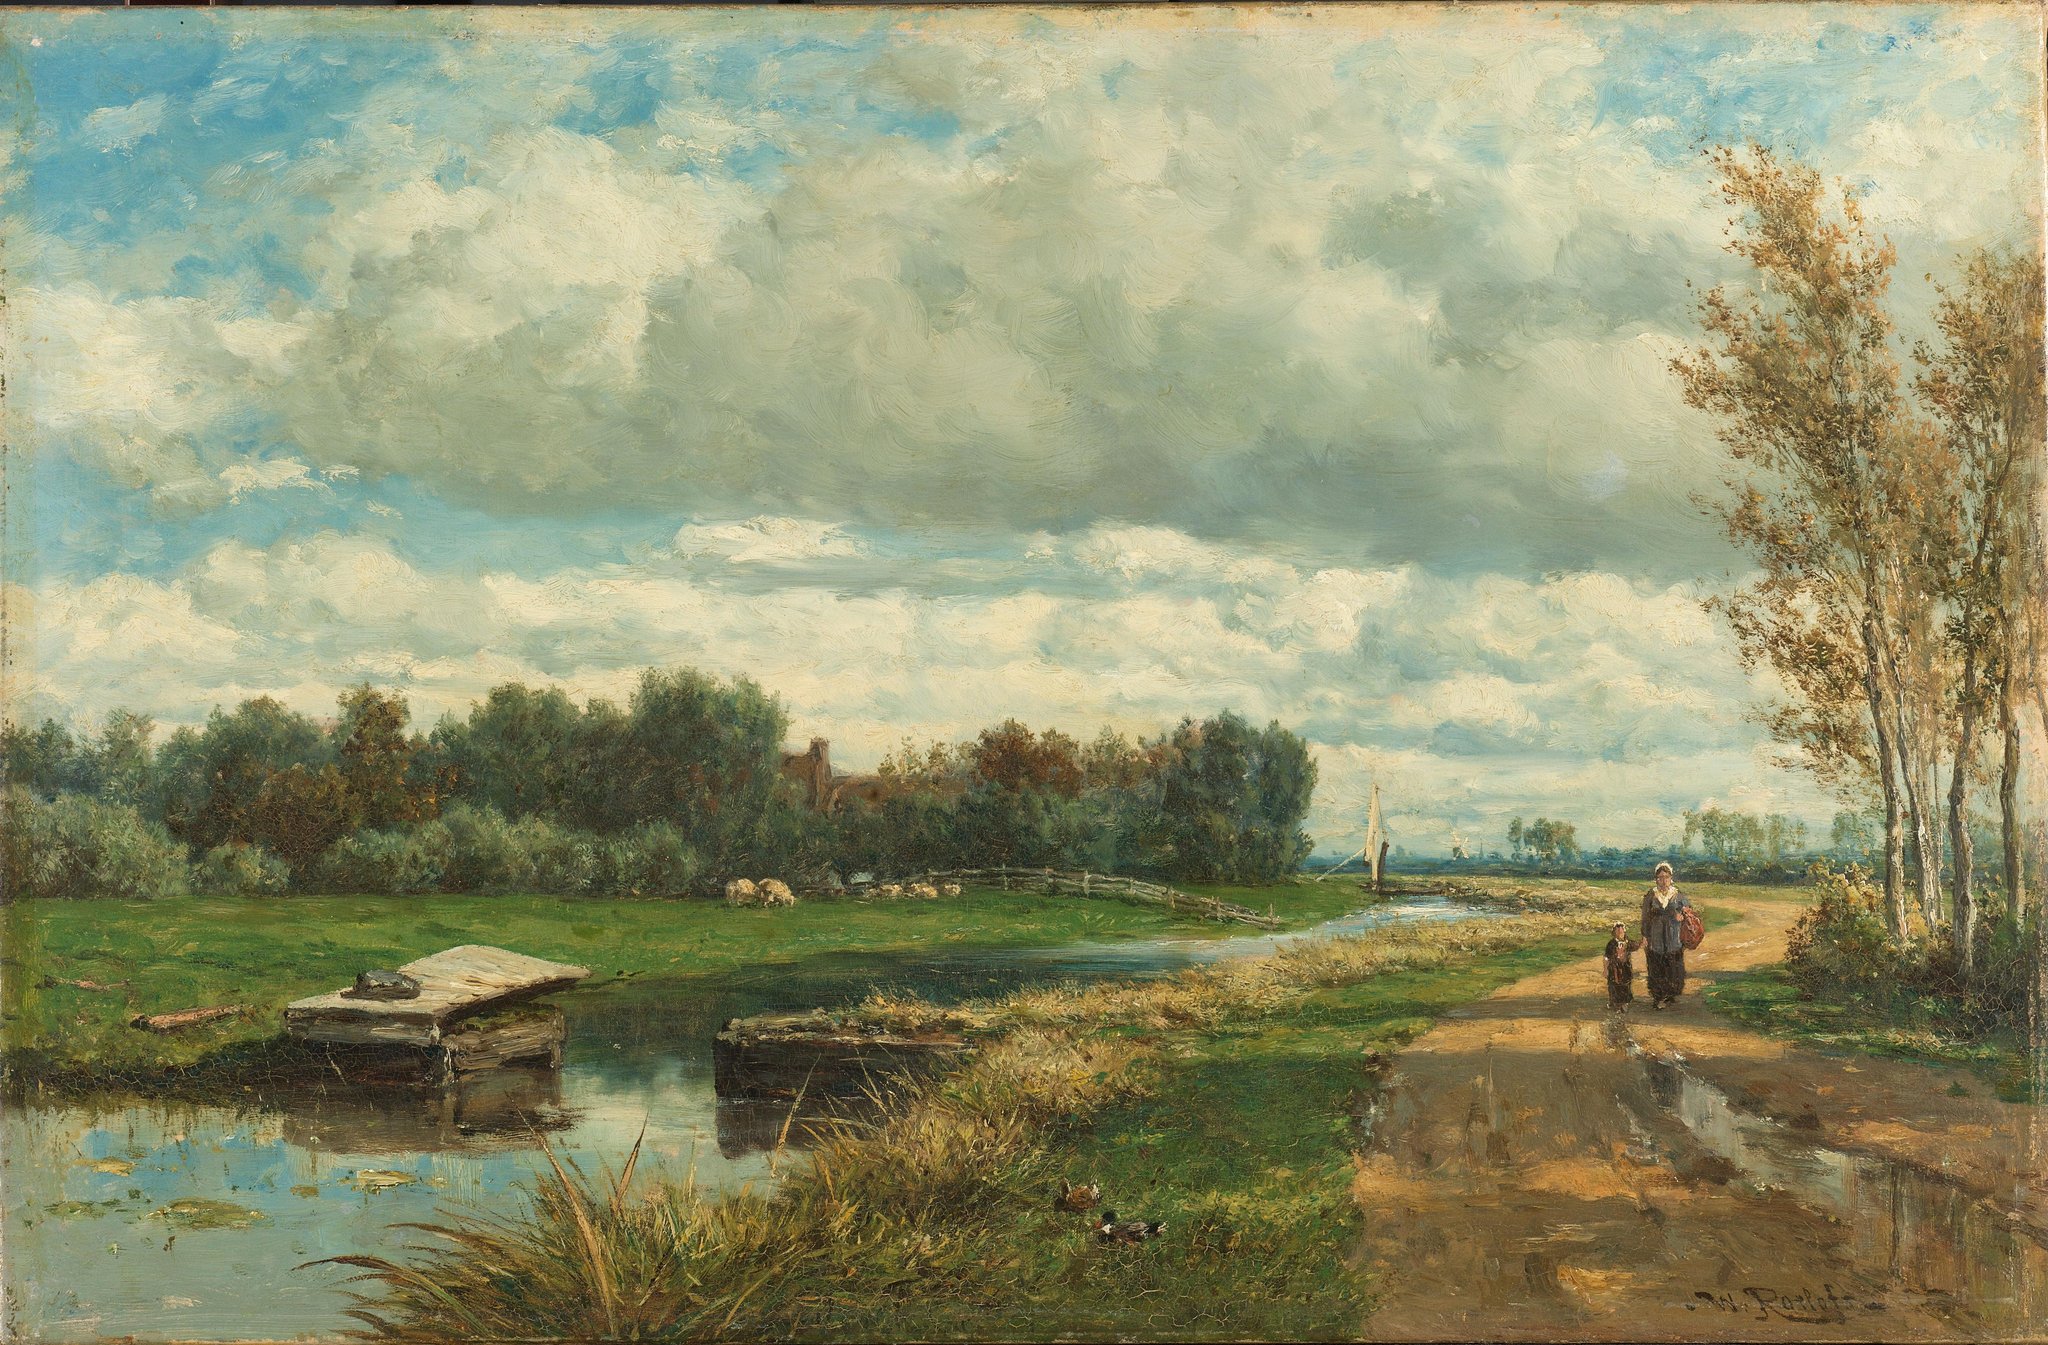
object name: painting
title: Landscape in the Environs of The Hague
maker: willem roelofs (i)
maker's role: draughtsman, painter, print maker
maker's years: 1822-1897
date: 1870-1875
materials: canvas, oil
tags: canal, road, path, the hague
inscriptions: signature: ‘W. Roelofs’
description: Together with Jozef Israëls, Roelofs is considered the doyen of the Hague School, even though he lived in Brussels. During the summer he made oil sketches in the environs of The Hague, which he worked up into paintings during the winter in his Brussels studio. Depicted here is the road from The Hague to the village of Stompwijk. The swing bridge across the canal is open to prevent the cattle from escaping.